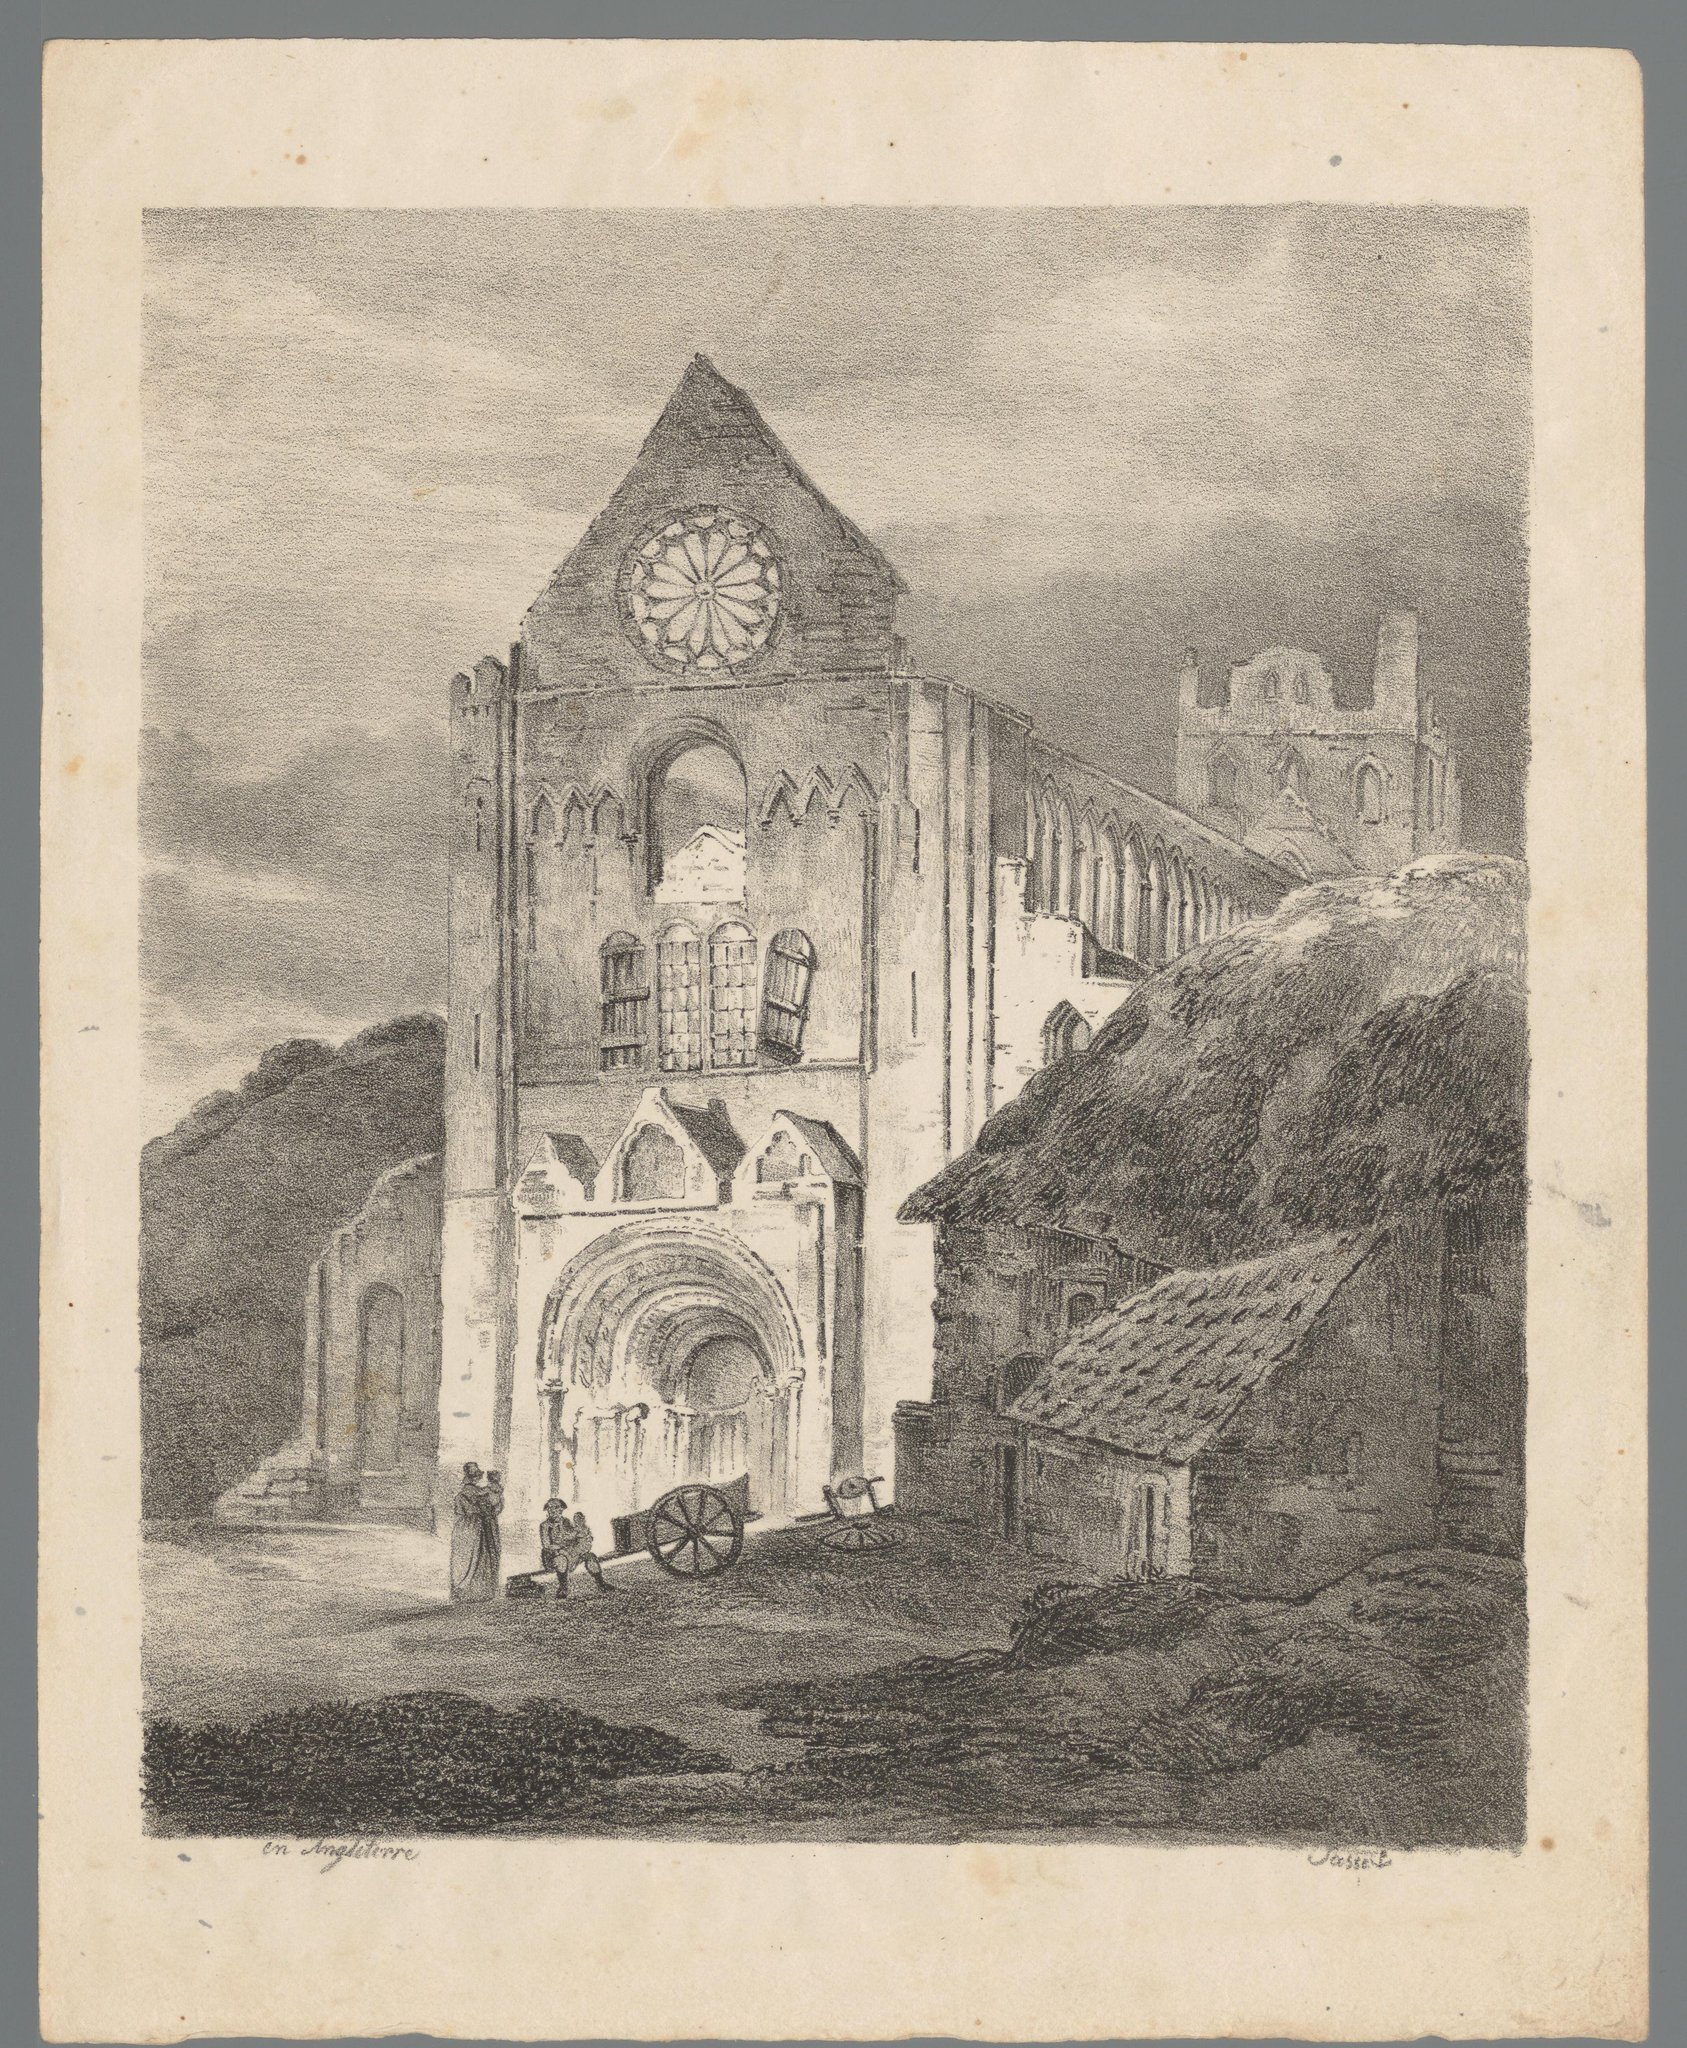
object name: print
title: L'art de dessiner le paysage d'apres nature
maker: richard sasse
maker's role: print maker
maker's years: 1774-1849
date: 1800-1849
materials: paper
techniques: lithograph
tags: abbey, monastery, convent ~ roman catholic church, landscape with ruins (+ city(-scape) with figures, staffage), england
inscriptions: collector's mark: Lugt 2228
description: Prent behoort tot de serie 'L'art de dessiner le paysage d'apres nature'. Deze serie is in tien delen met elk zes lithografieën uitgegeven.